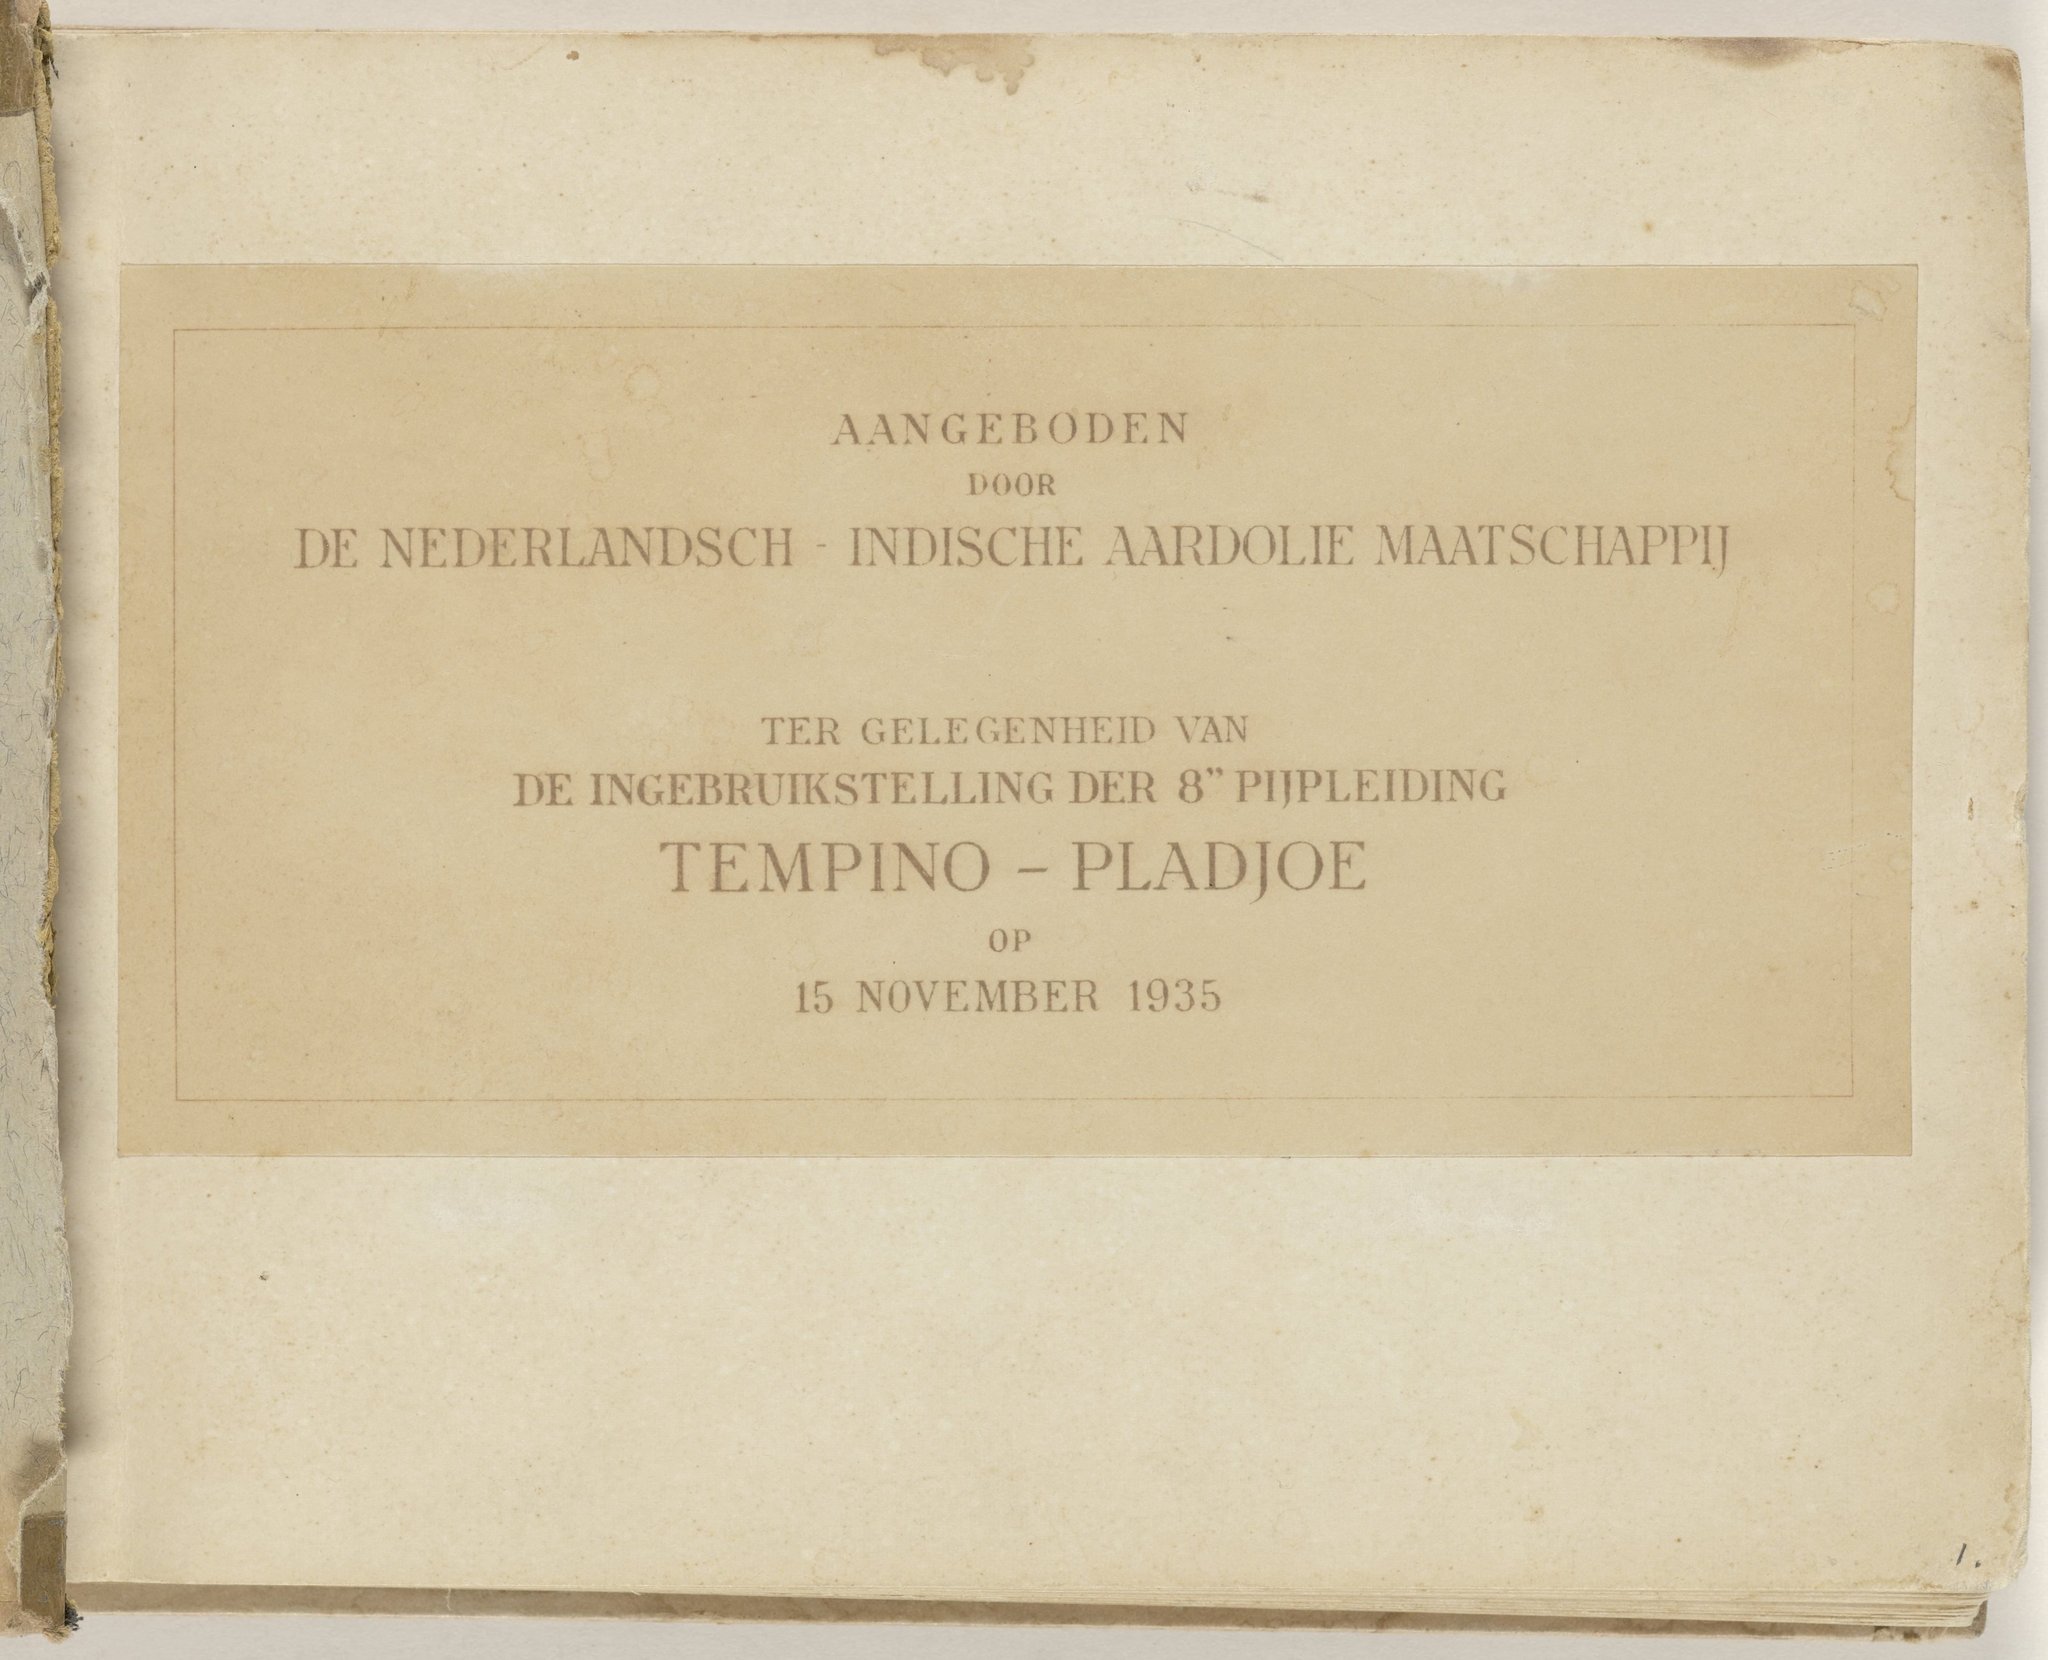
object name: reproduction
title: Titelblad van het fotoalbum ter gelegenheid van de ingebruikstelling van de 8" pijpleiding Tempino-Pladjoe door de Nederlandsch-Indische Aardolie Maatschappij in 1935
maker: Anonymous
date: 1935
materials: paper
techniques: printing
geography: sumatra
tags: utrecht, germany, colonial system, pipeline ~transportation of oil, sumatra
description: Reproductie van tekst als titelblad van het fotoalbum samengesteld ter gelegenheid van de feestelijke ingebruikstelling van de pijpleiding van Tempino naar Pladjoe op Sumatra door de Nederlandsch-Indische Aardolie Maatschappij (NIAM) op 15 november 1935.